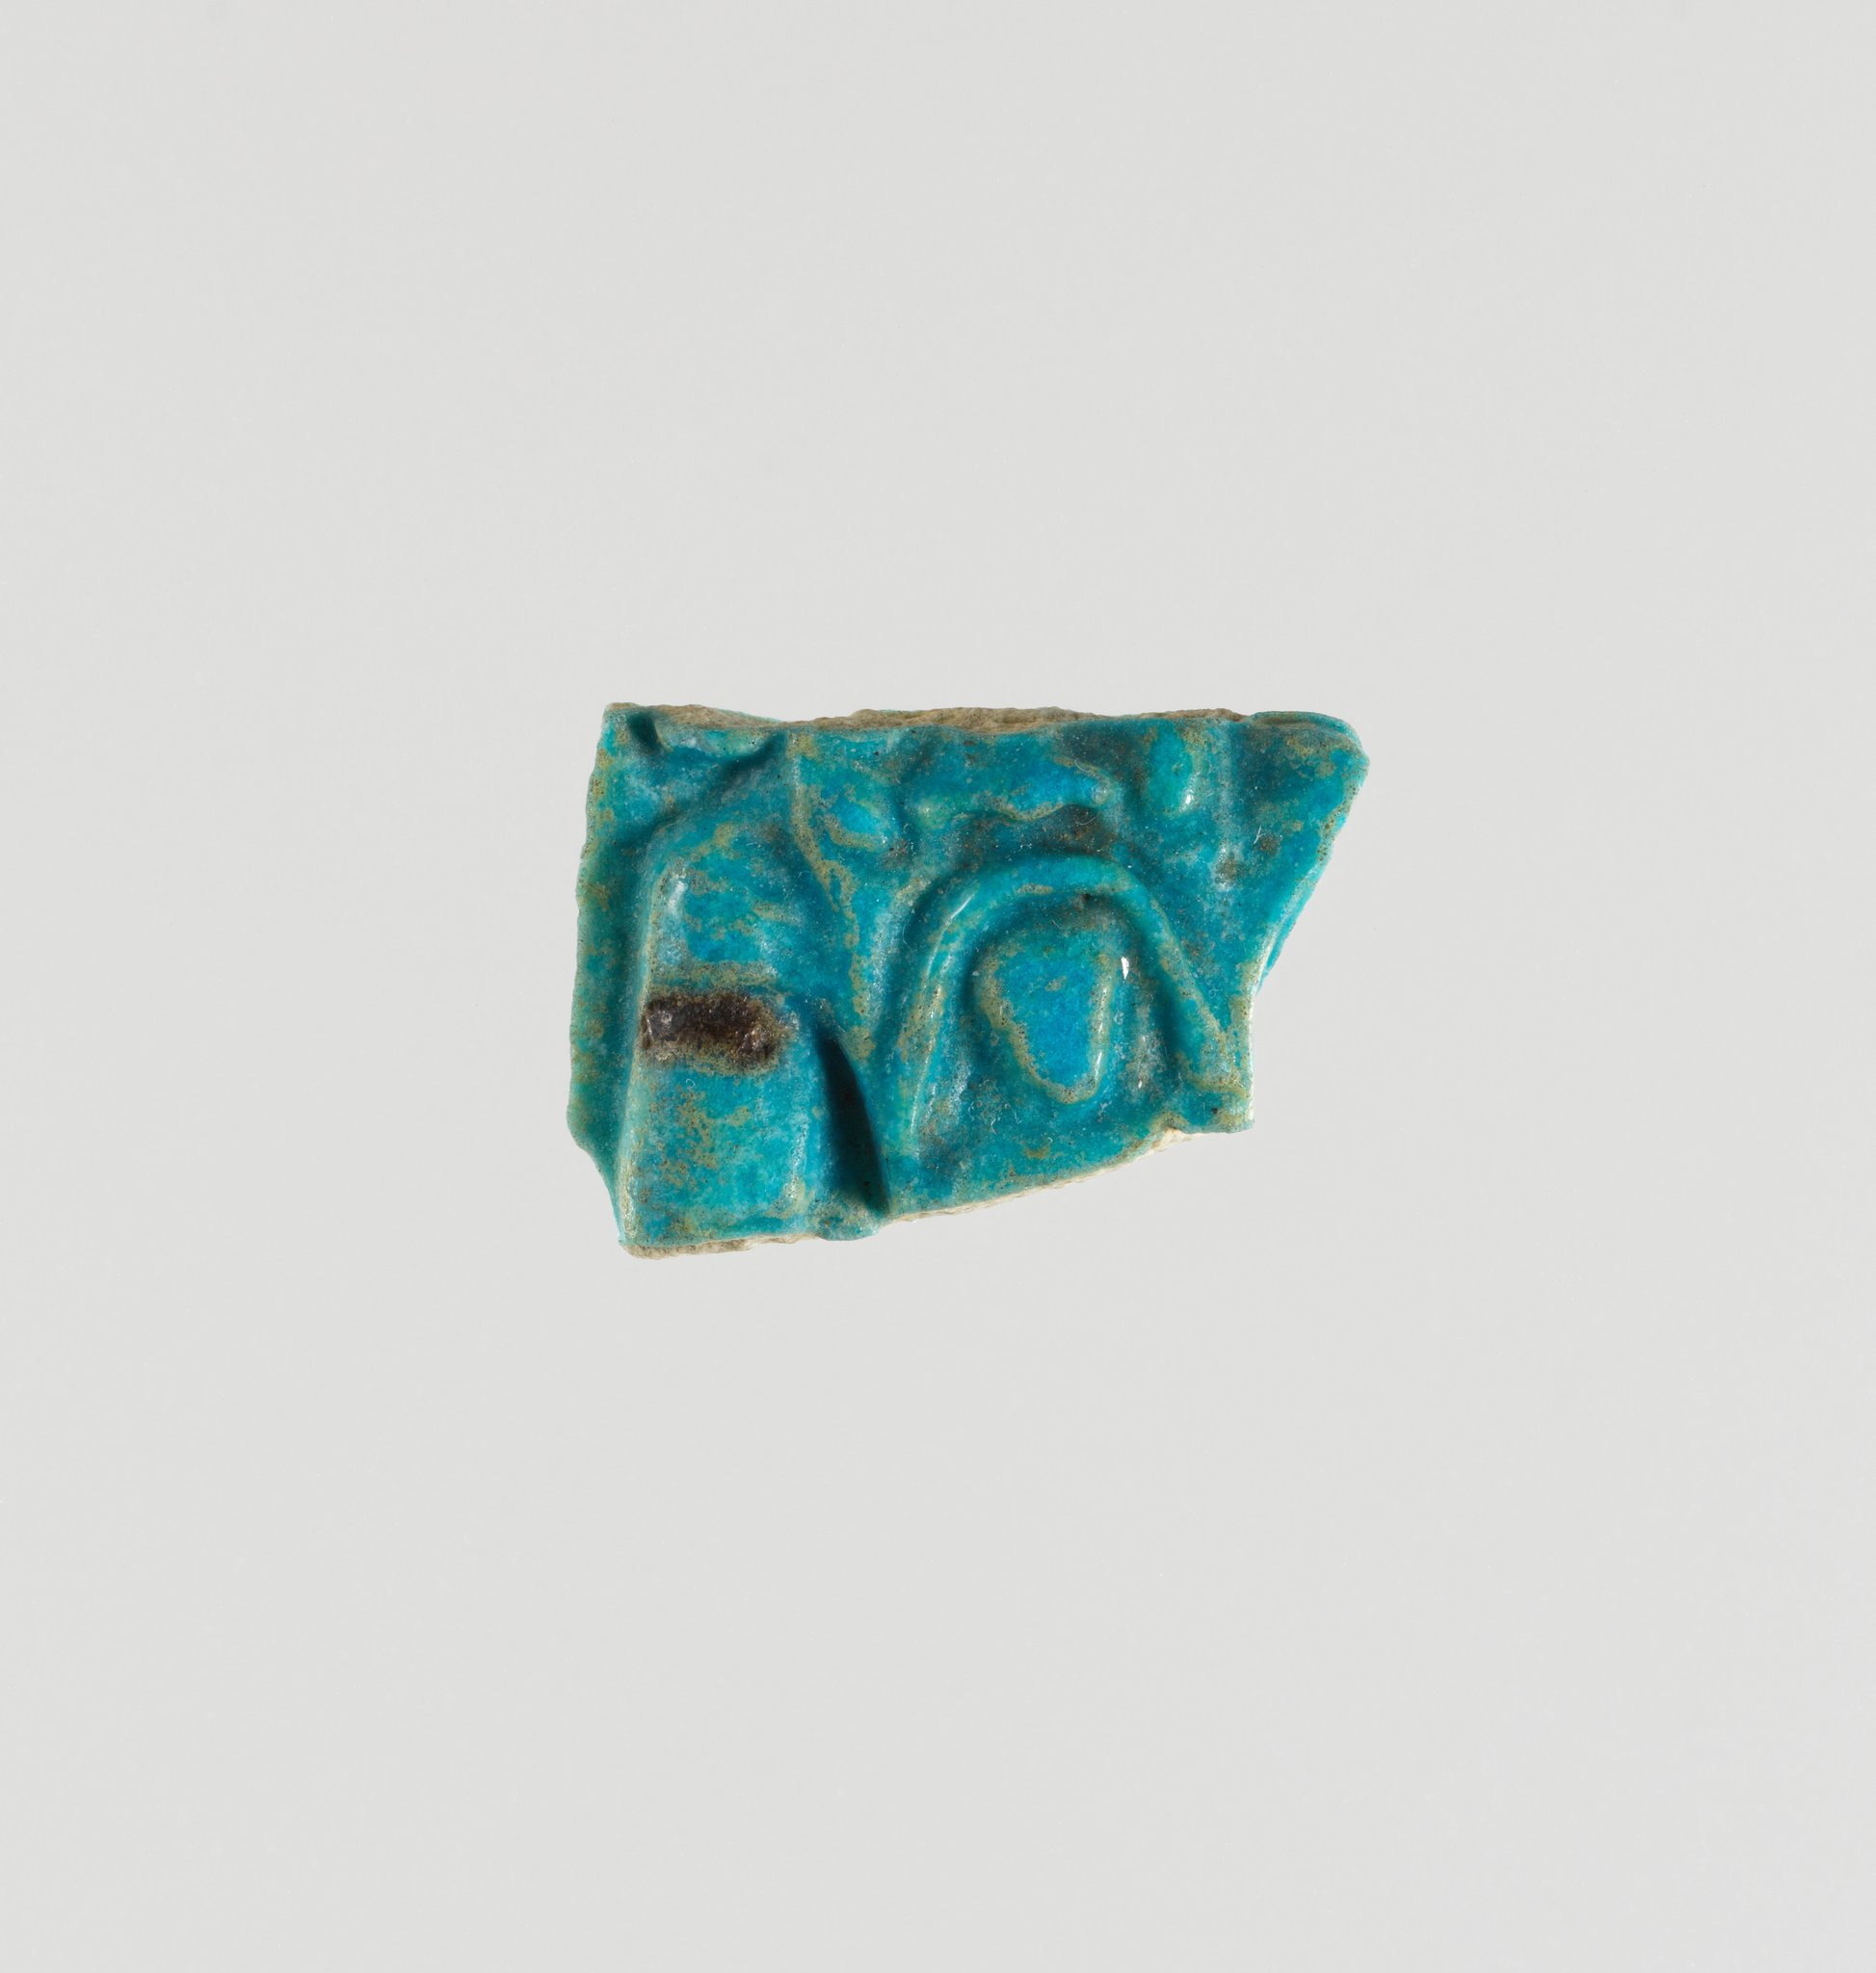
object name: chalice, cup, lotiform, relief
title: Wall fragment of a chalice with Bes face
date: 1070-664 BCE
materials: faience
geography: egypt